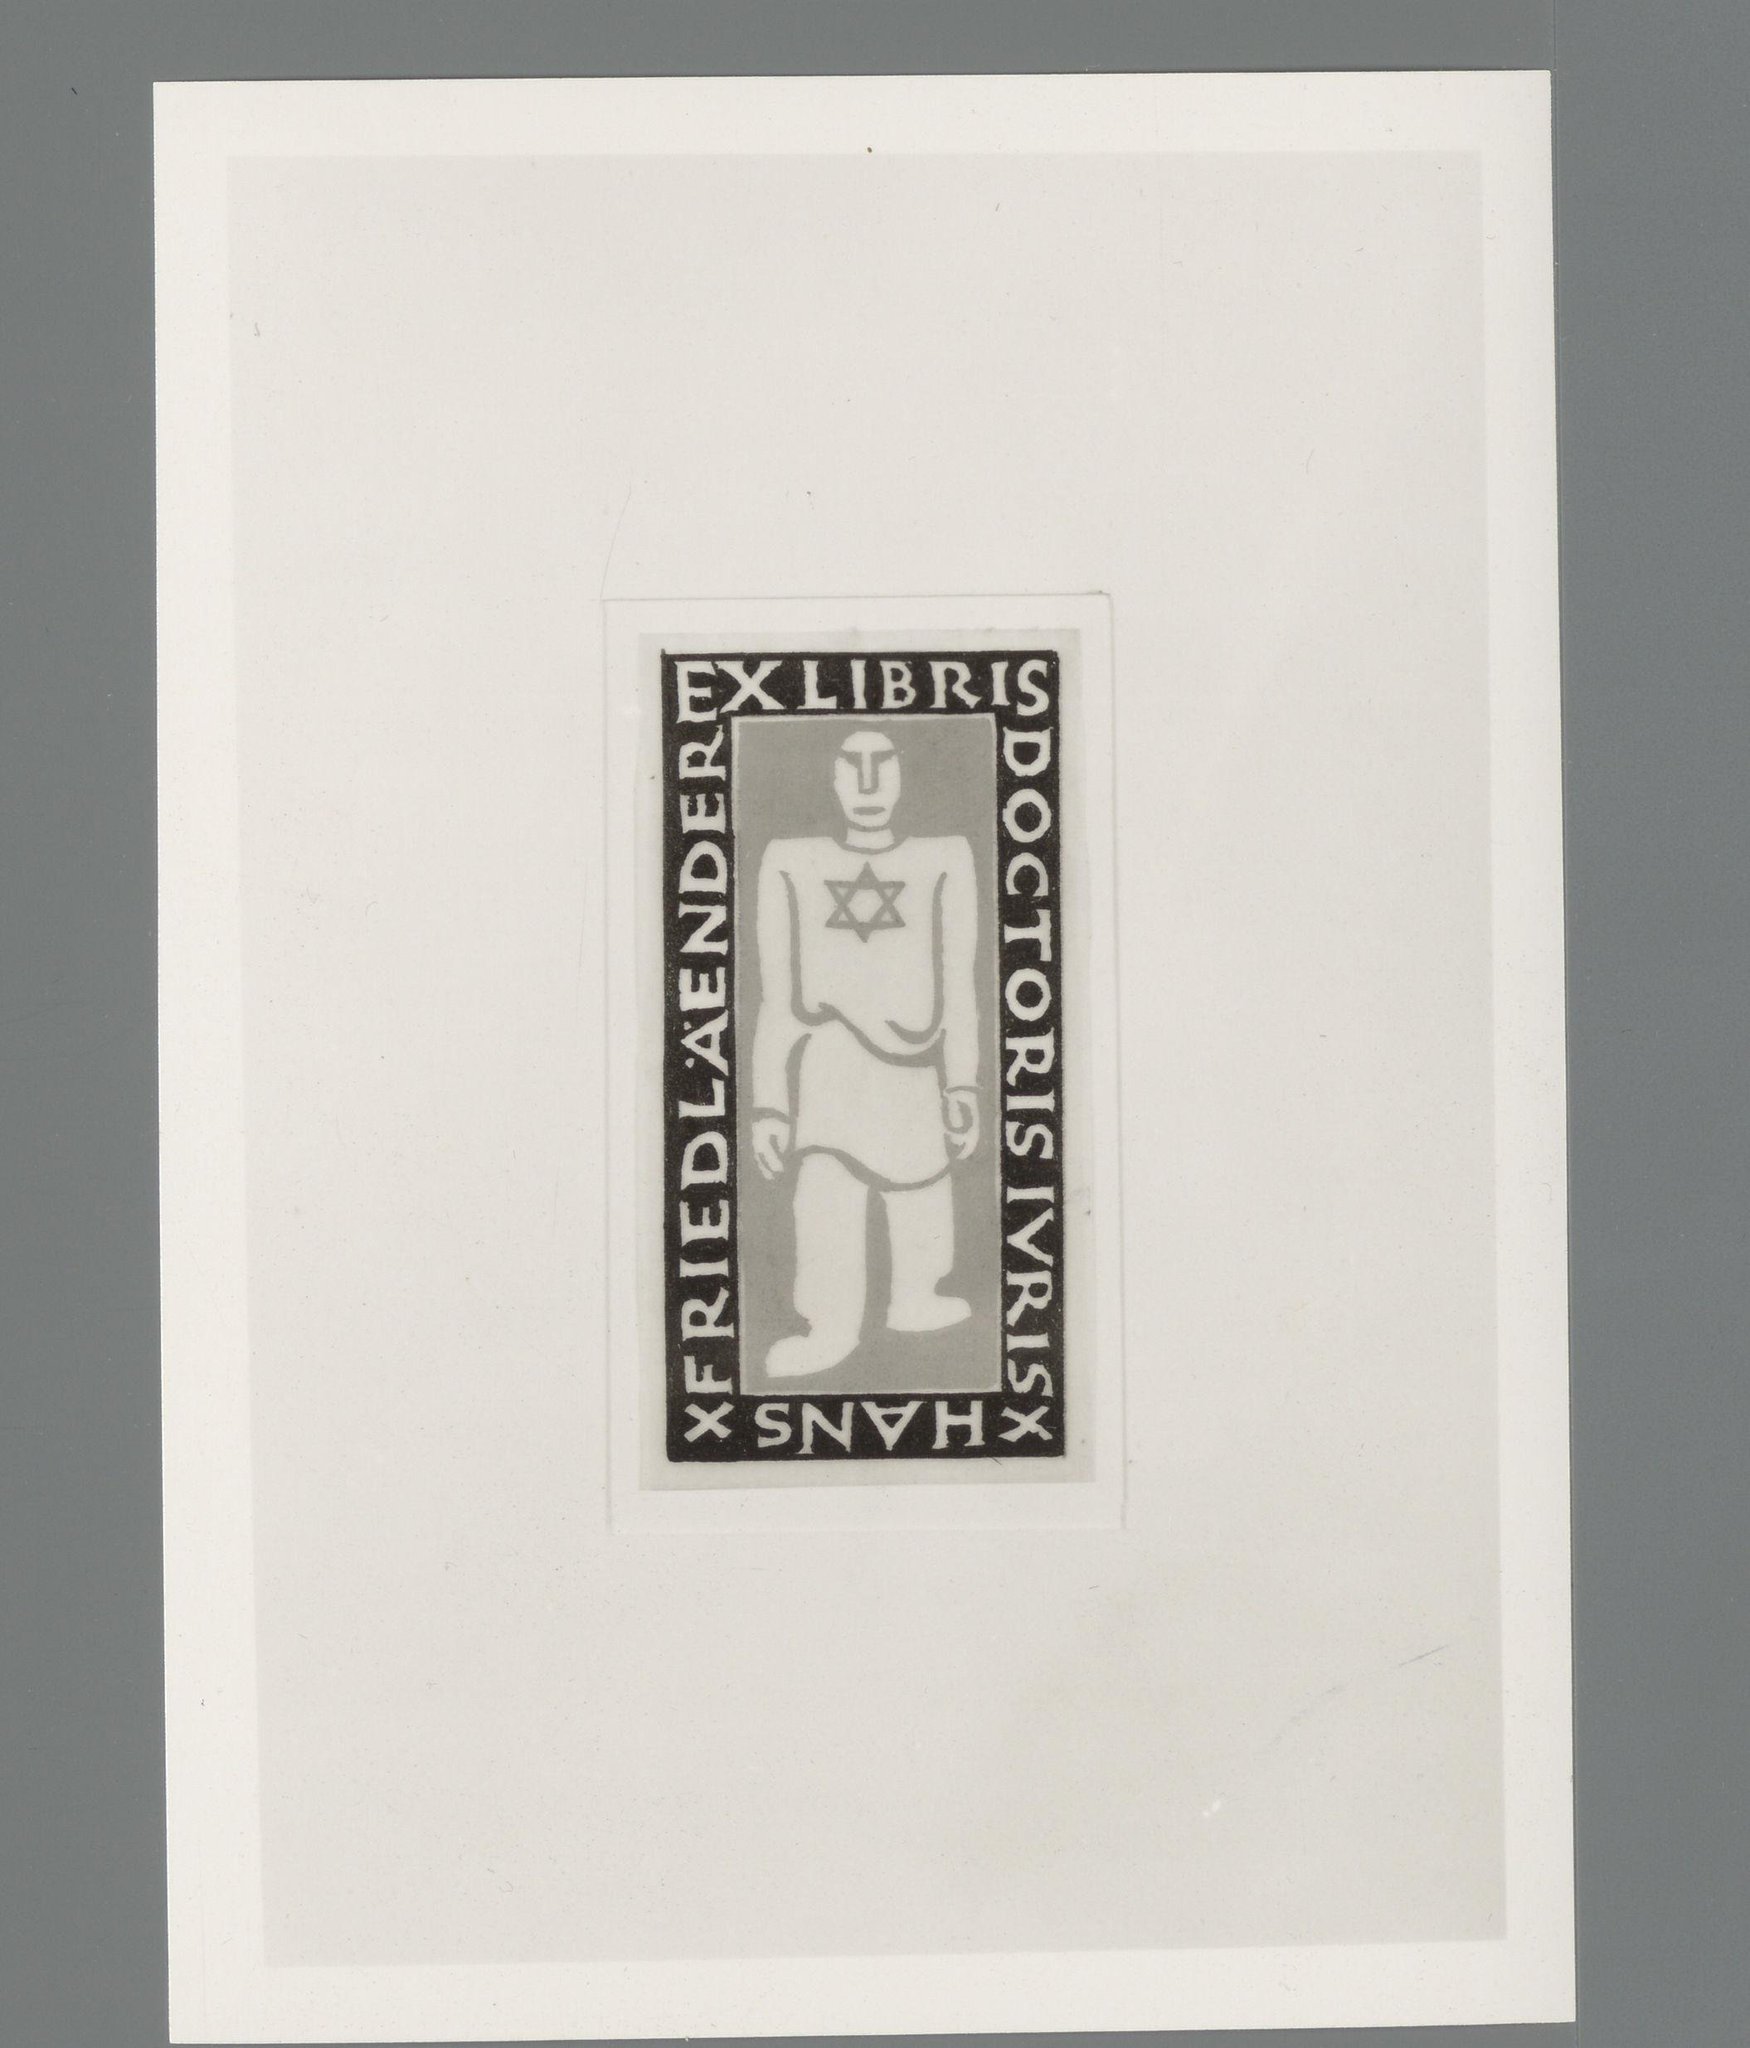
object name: photograph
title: Ex libris van Hans Friedländer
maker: Anonymous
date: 1937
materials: paper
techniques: gelatin silver print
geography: germany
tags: standing figure, jewish religion and culture